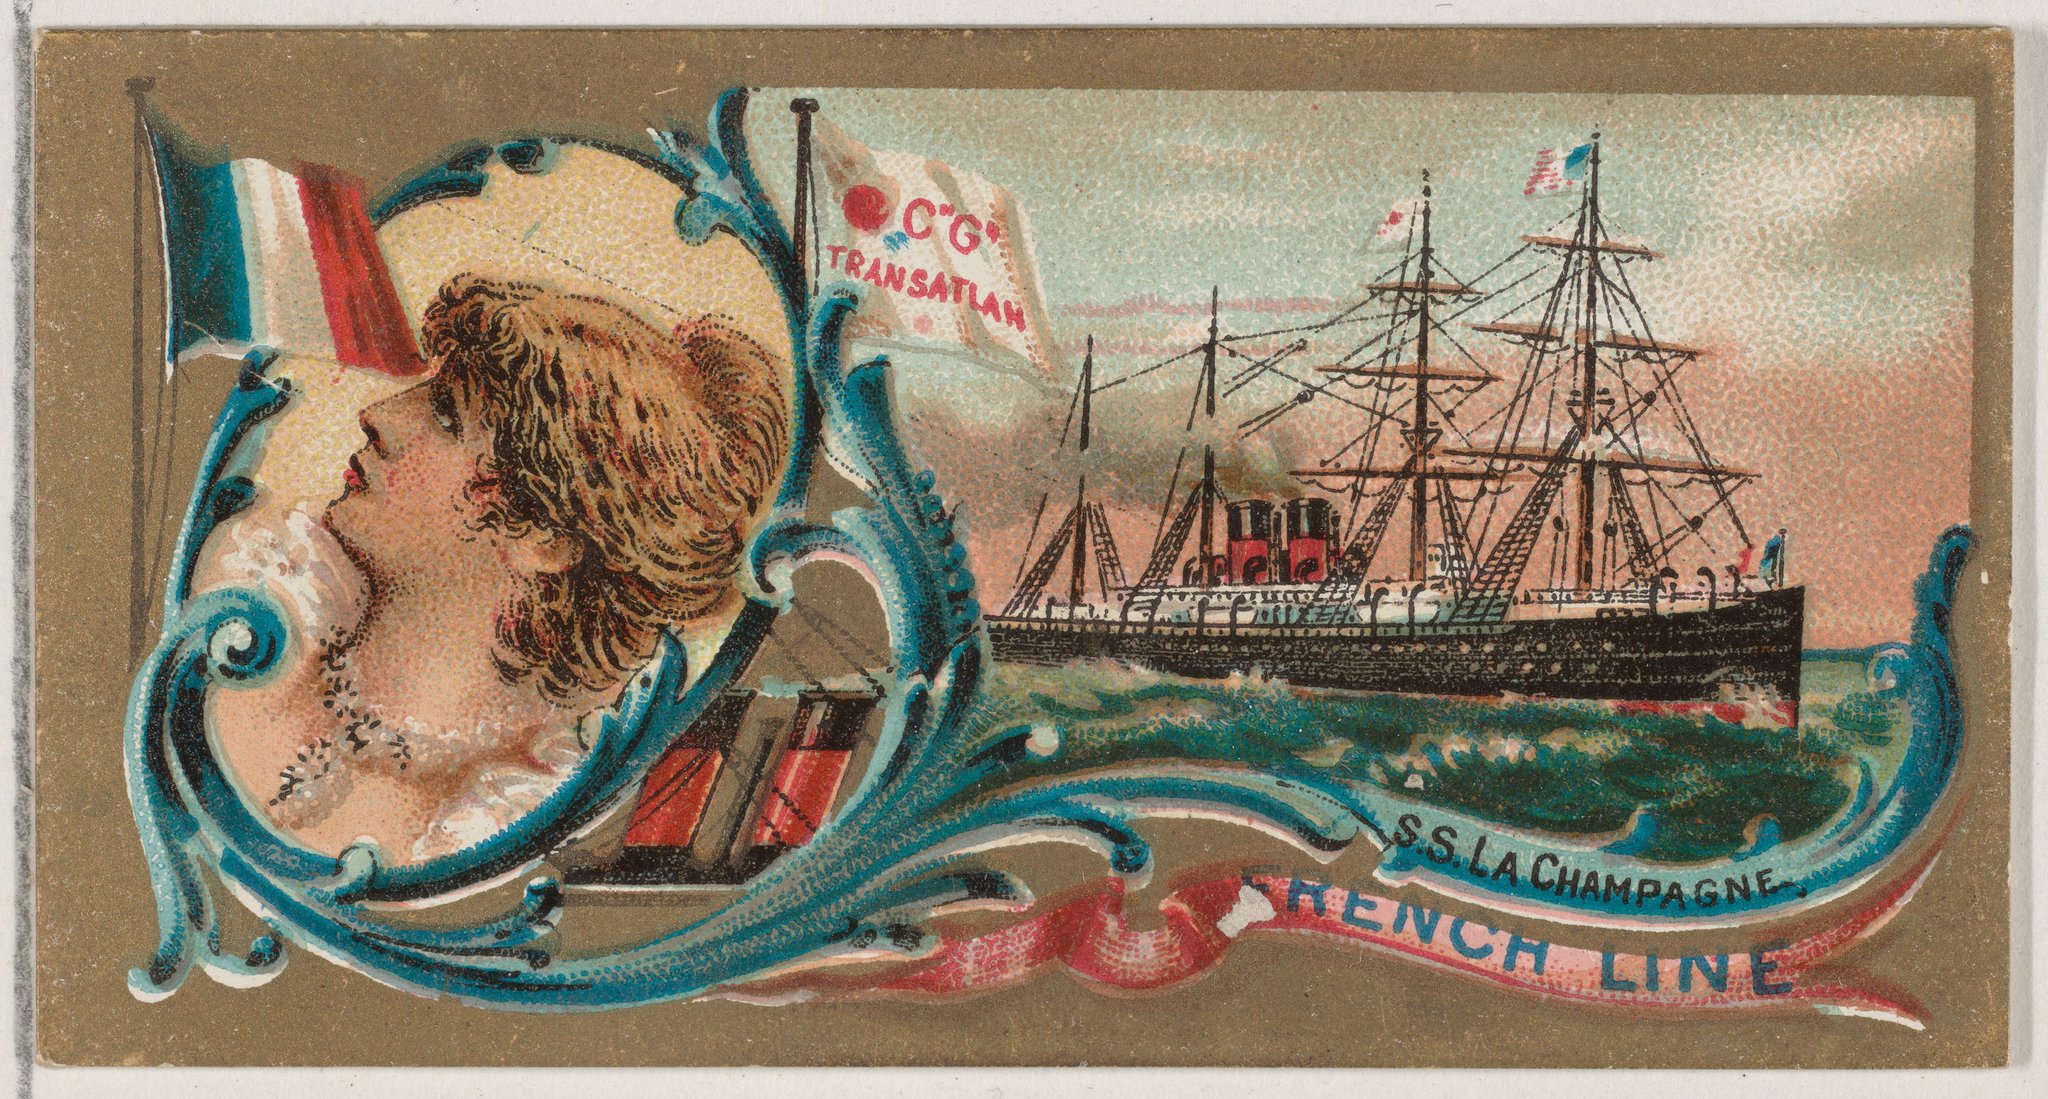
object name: print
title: Steamship La Champagne, French Line, from the Ocean and River Steamers series (N83) for Duke brand cigarettes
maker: w. duke, sons & co.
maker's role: publisher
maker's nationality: american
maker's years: 1870-1920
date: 1887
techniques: color lithograph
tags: women,ships